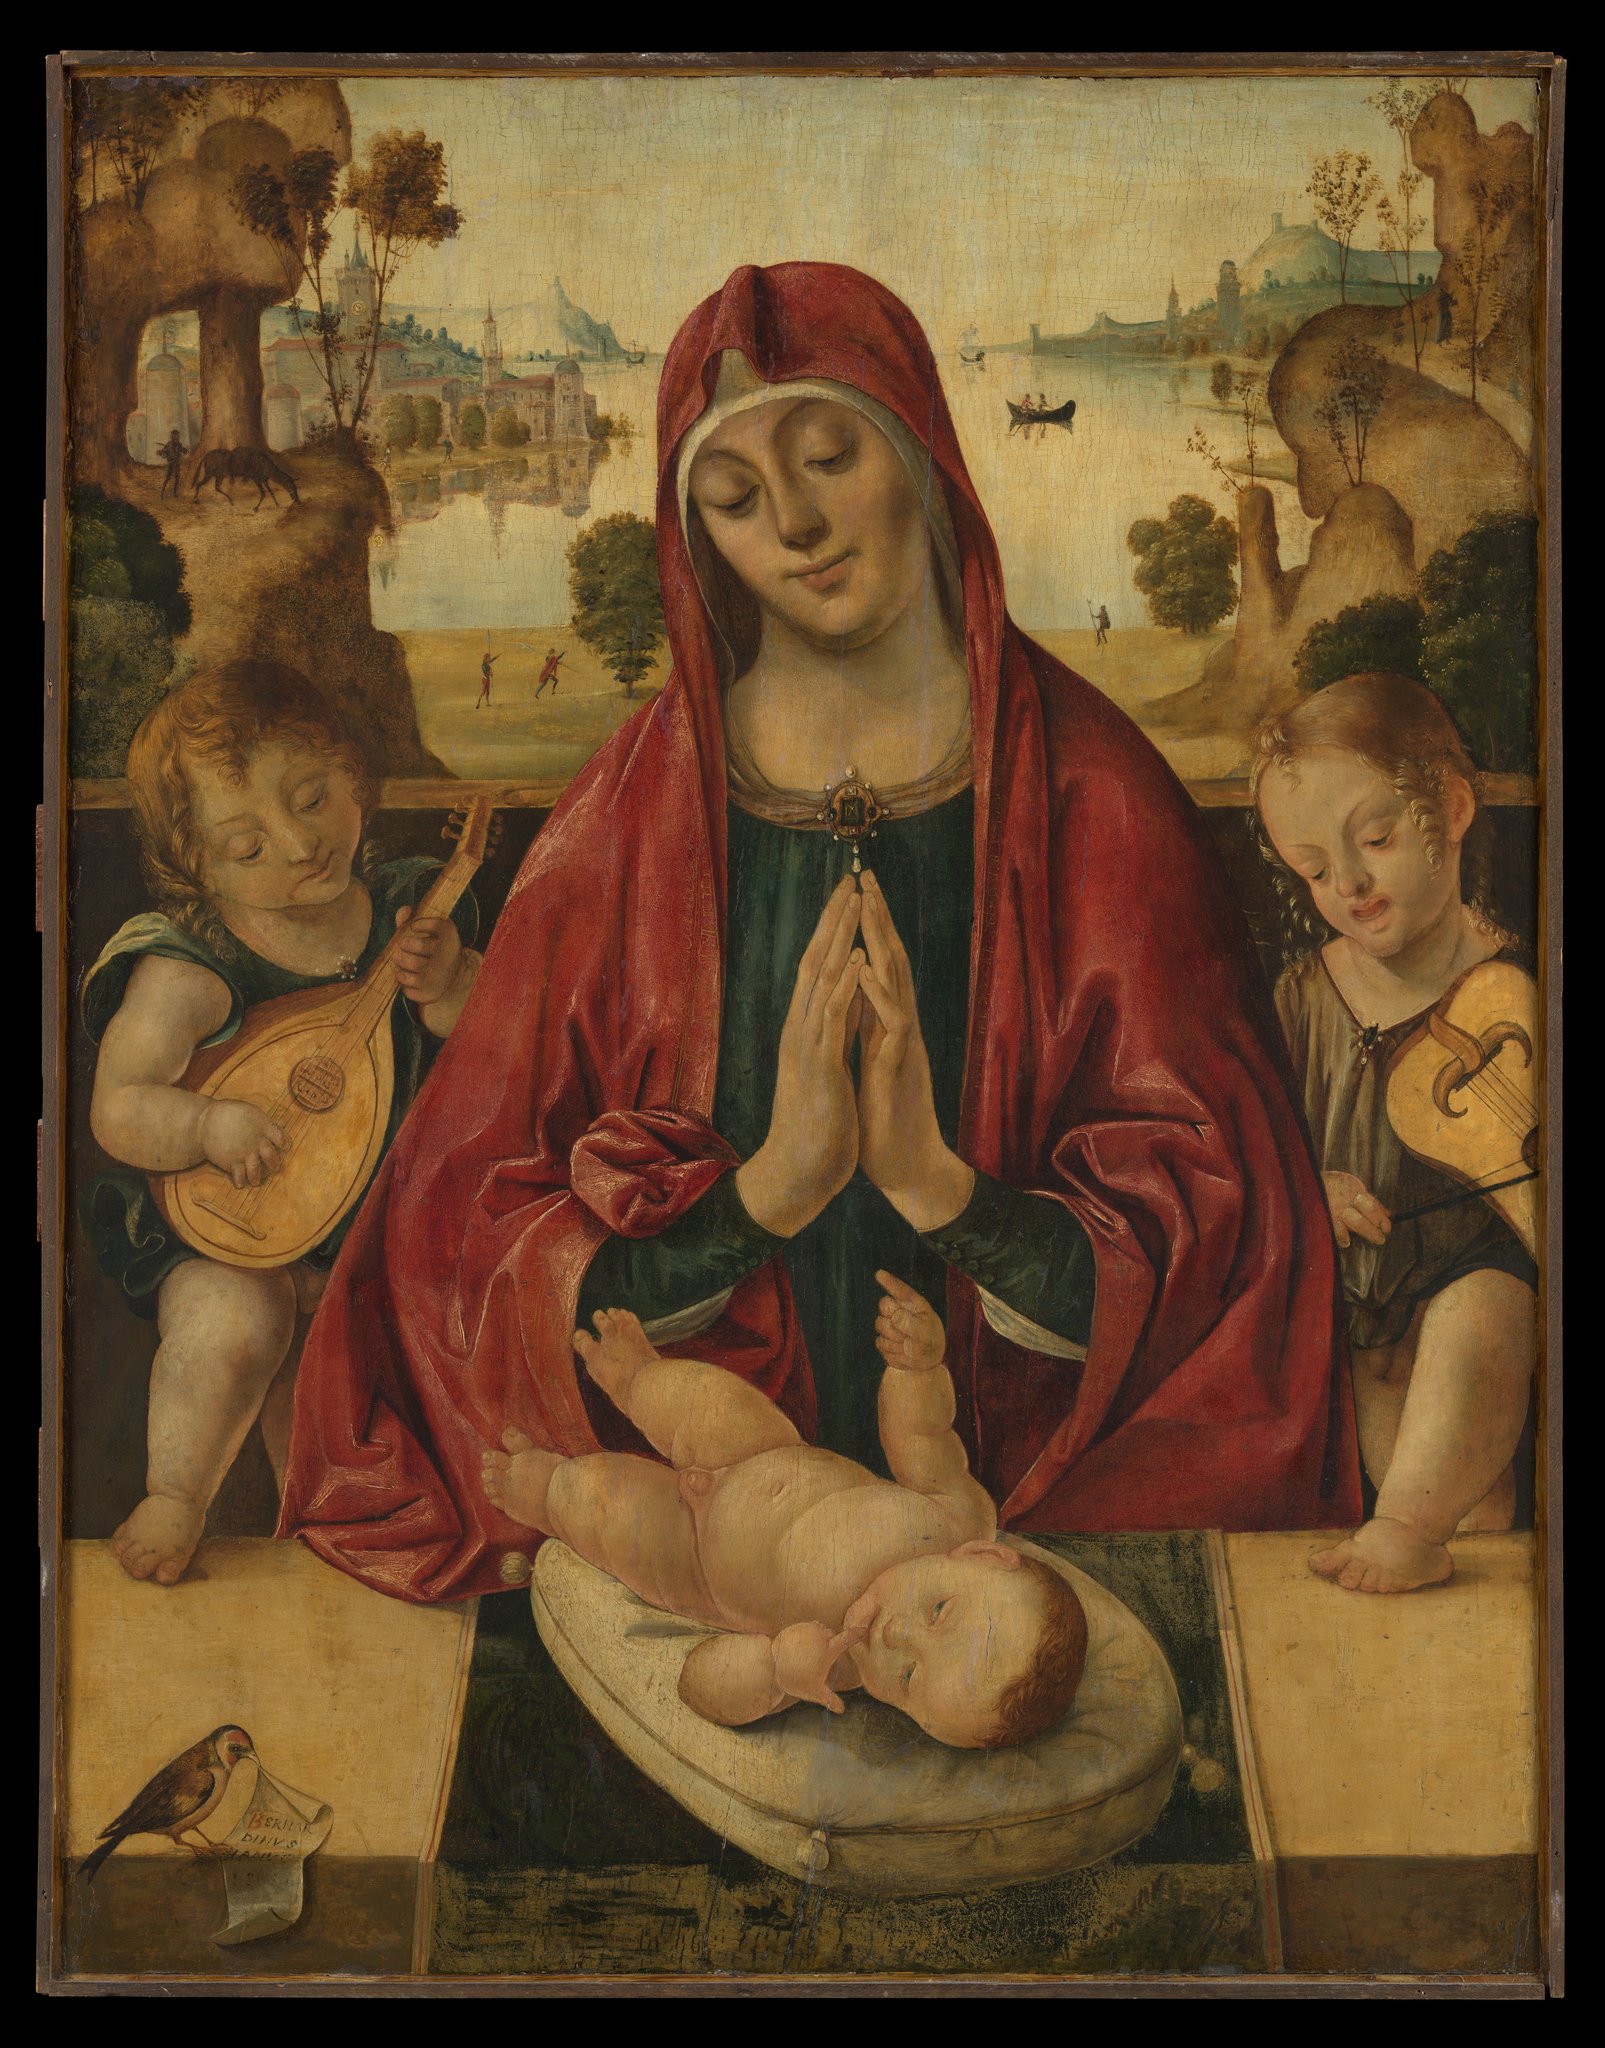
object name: painting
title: Madonna and Child with Angels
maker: bernardino da genoa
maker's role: artist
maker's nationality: italian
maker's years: 1515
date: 1515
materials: oil, wood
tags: birds,lutes,angels,madonna and child